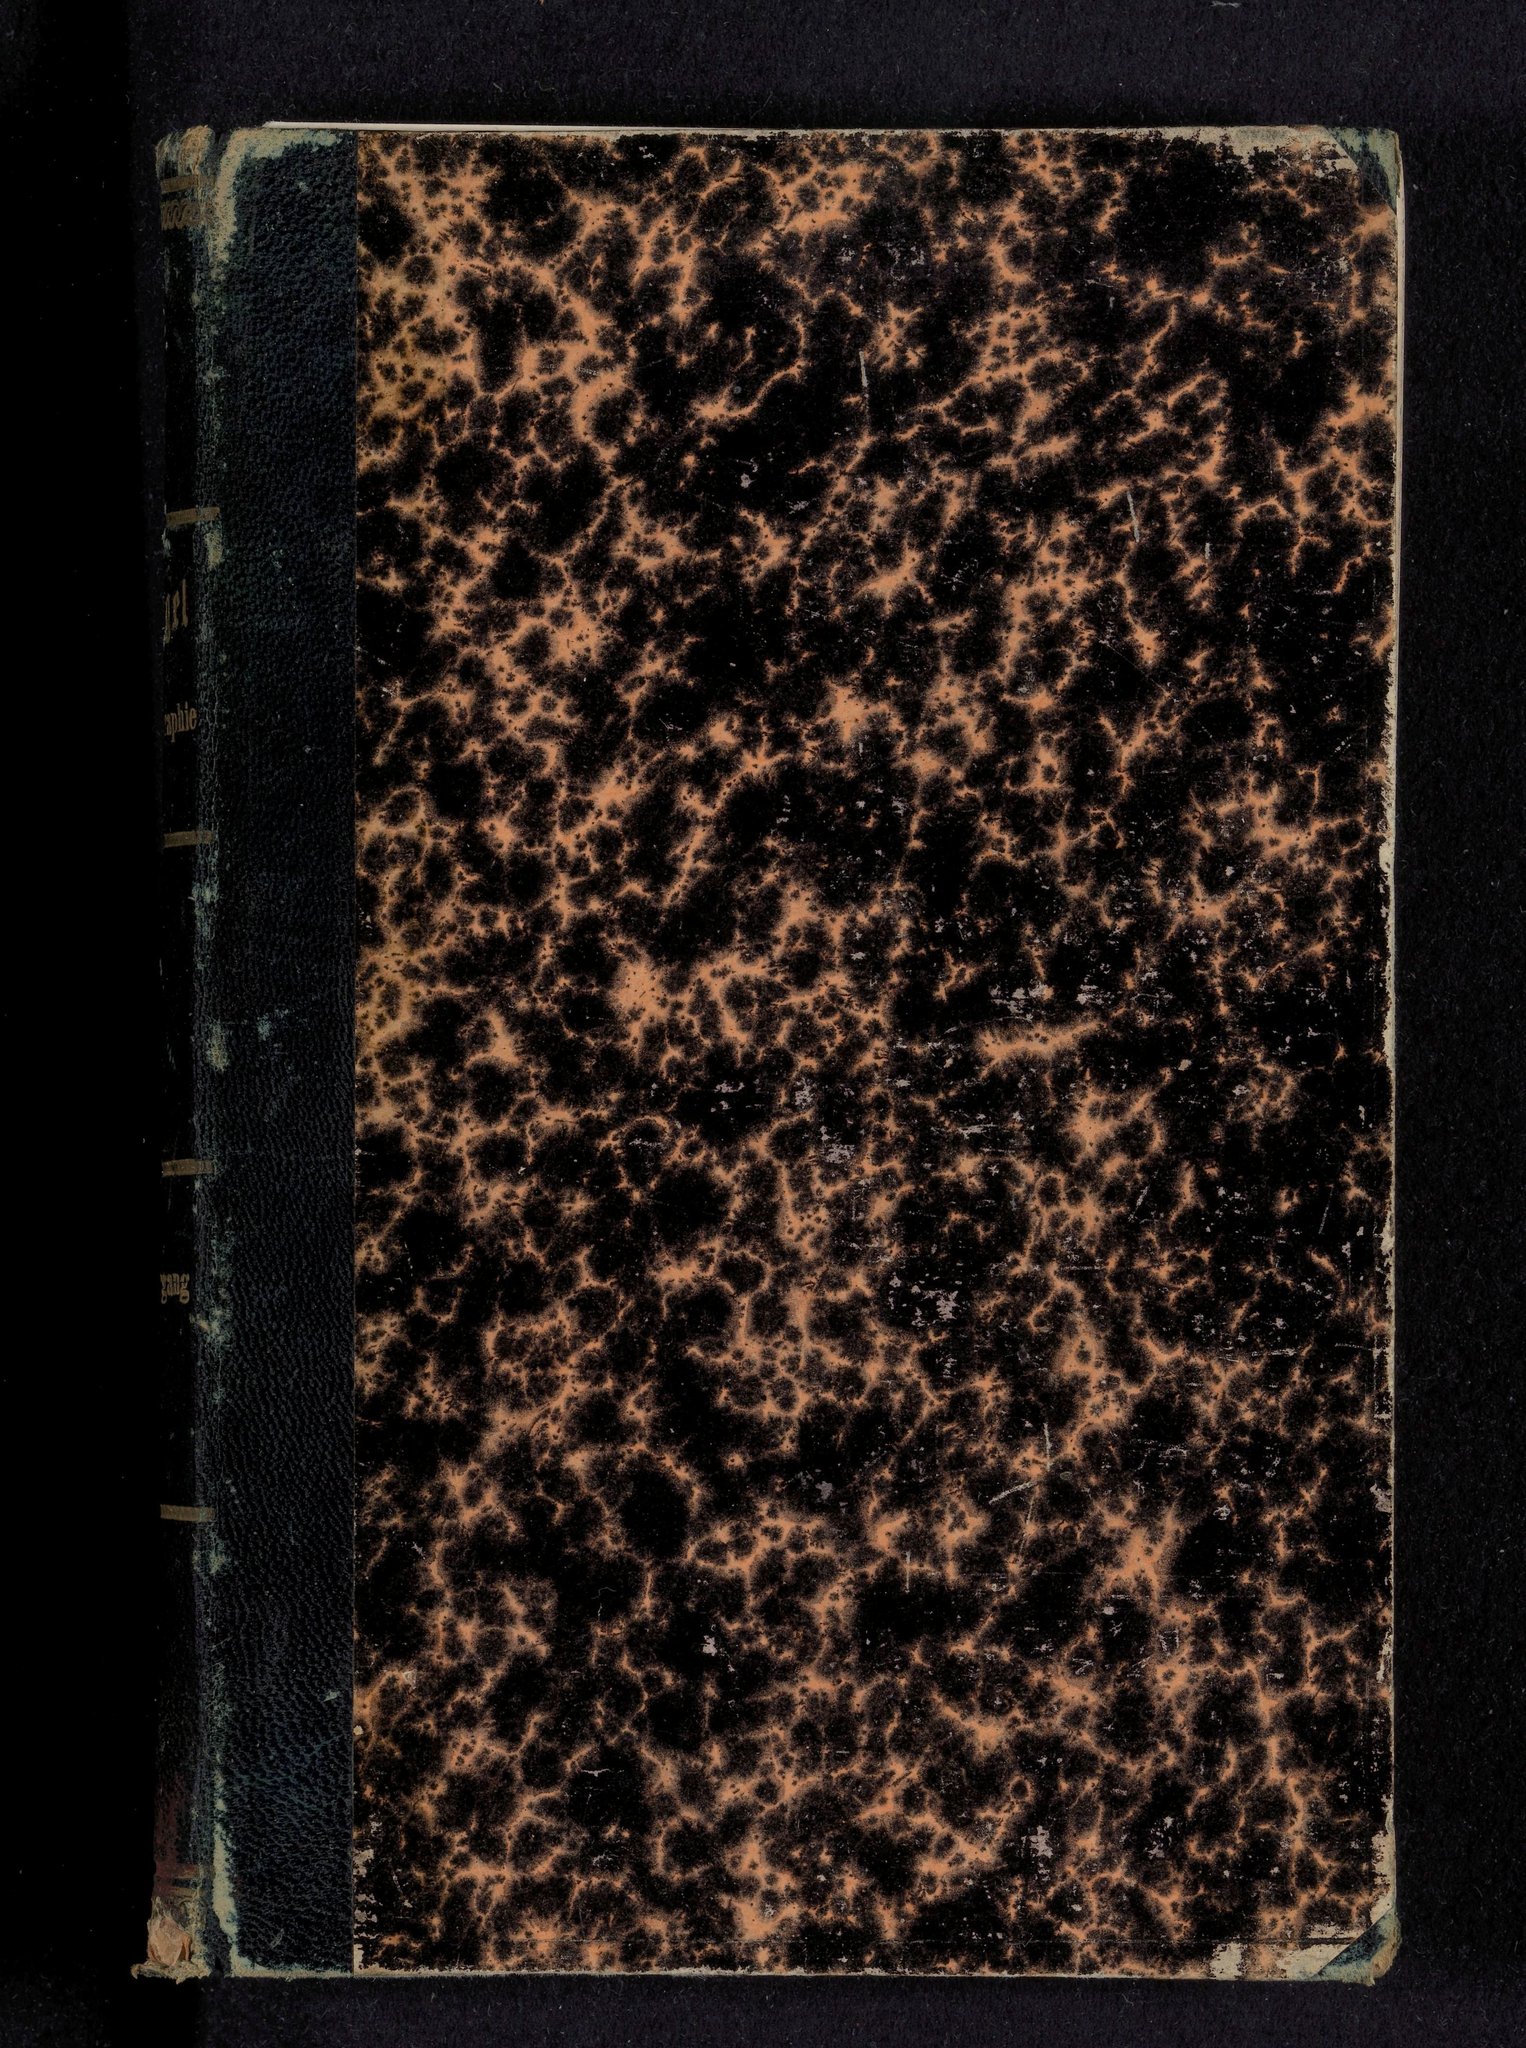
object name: book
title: Photographische Mittheilungen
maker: hermann wilhelm vogel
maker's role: chemicus, fotograaf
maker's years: 1834-1898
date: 1873-1874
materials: cardboard, paper, textile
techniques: marbled paper, albumen print, photograph, printing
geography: berlin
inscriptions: annotation: ‘OCT 1992’, annotation: ‘Photogr. Mitt. 10. Jg. (1873)/ "[...]"’